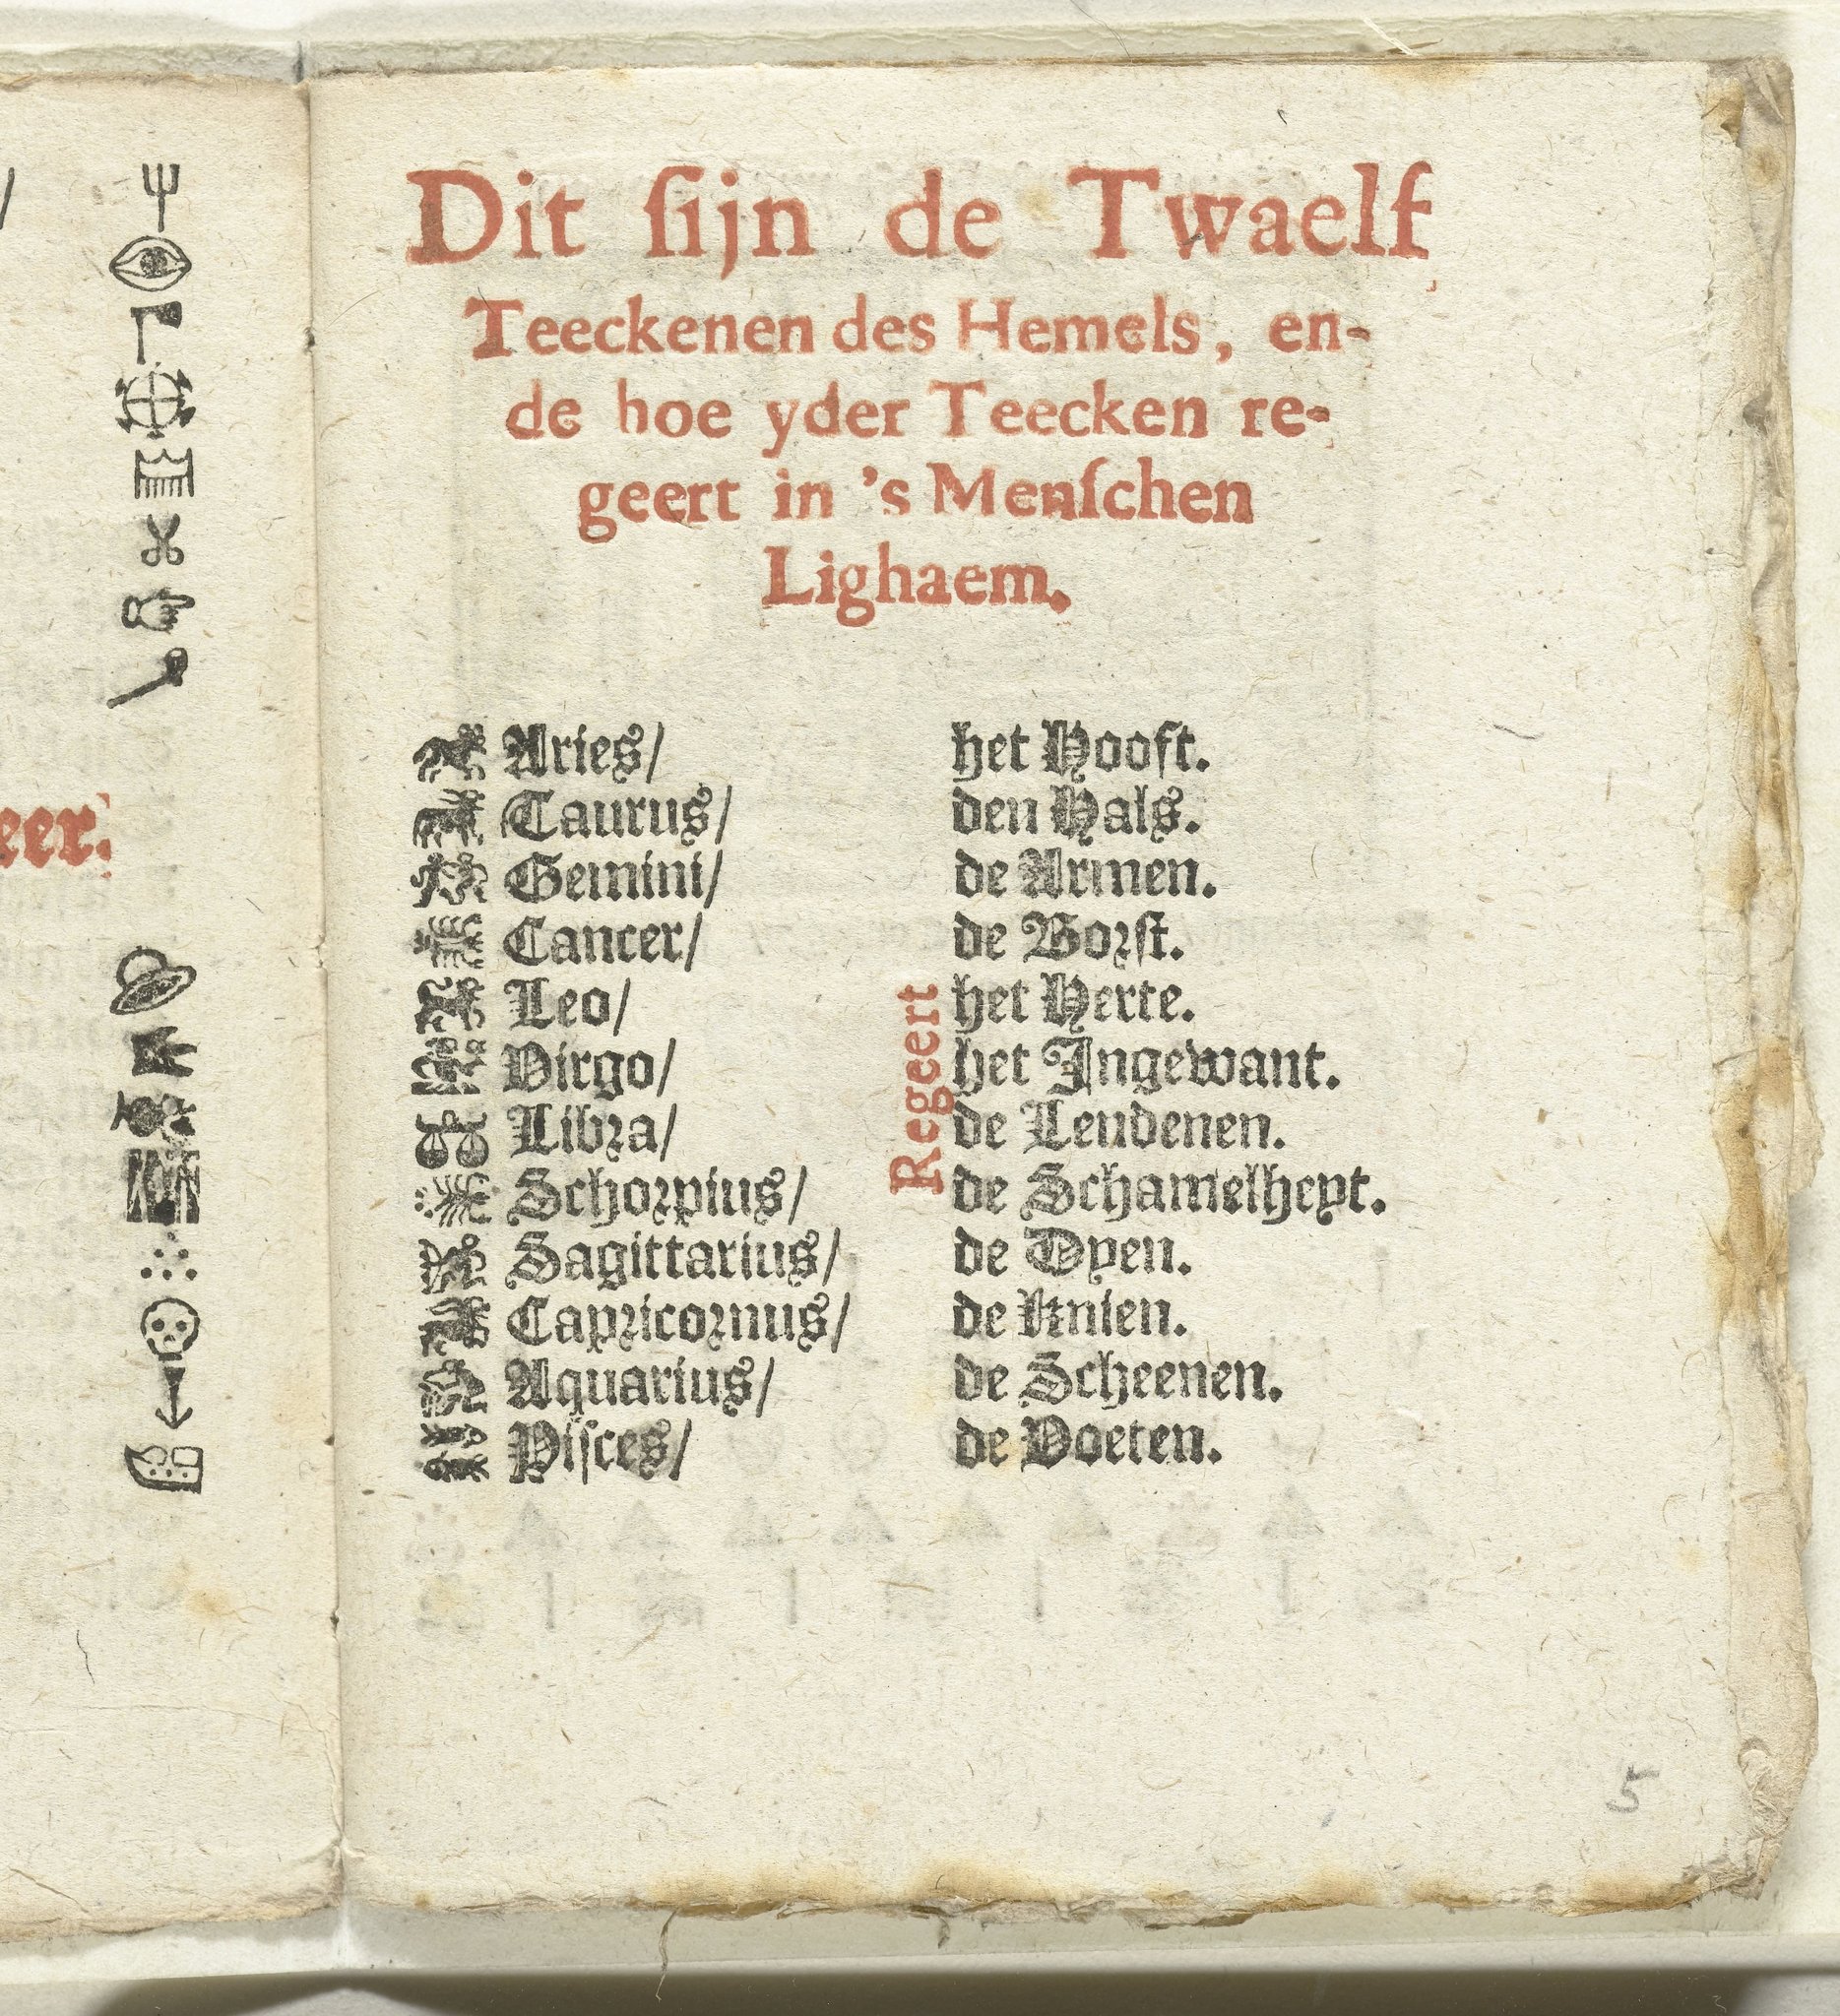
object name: print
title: Bladzijde met verklaring van gebruikte symbolen en tekens voor het weer, 1712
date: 1712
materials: paper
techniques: letterpress printing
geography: antwerp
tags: calendar, almanac, zodiac; the twelve zodiacal signs together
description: Bladzijde in: Den Boeren / Oft Schapers Almanach Voor 't Schrickel Jaer ins Heeren Jesu Christi, 1712. Antwerpen: bij Wed. Slegers 1712. Exemplaar in de Rijksmuseum Research Library (signatuur: 305 G 19).